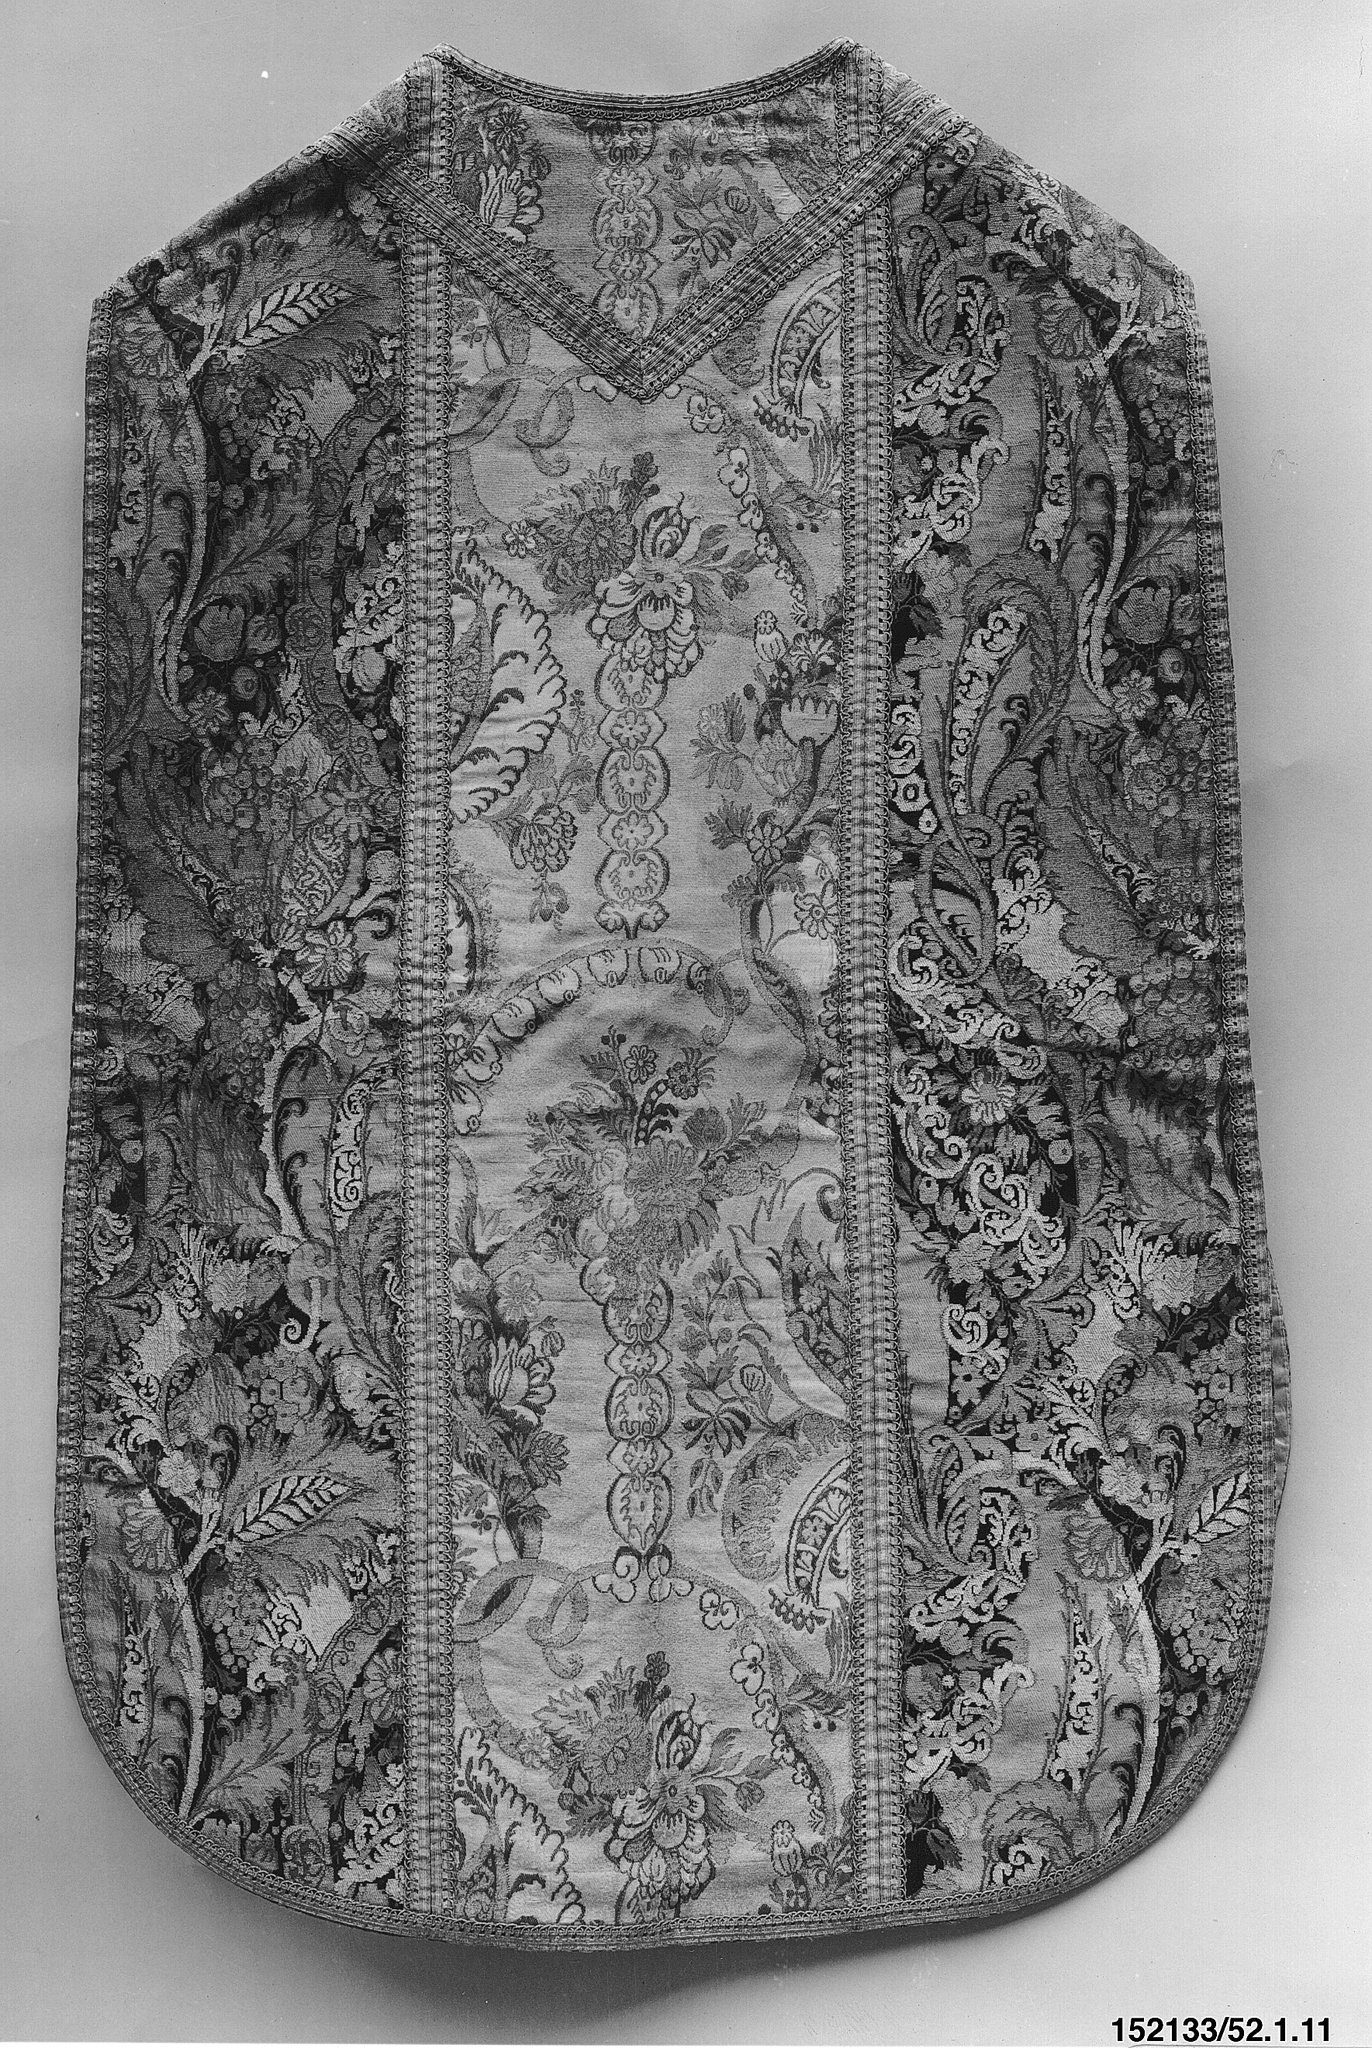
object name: chasuble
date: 1801-1900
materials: metal thread, silk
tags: flowers,leaves